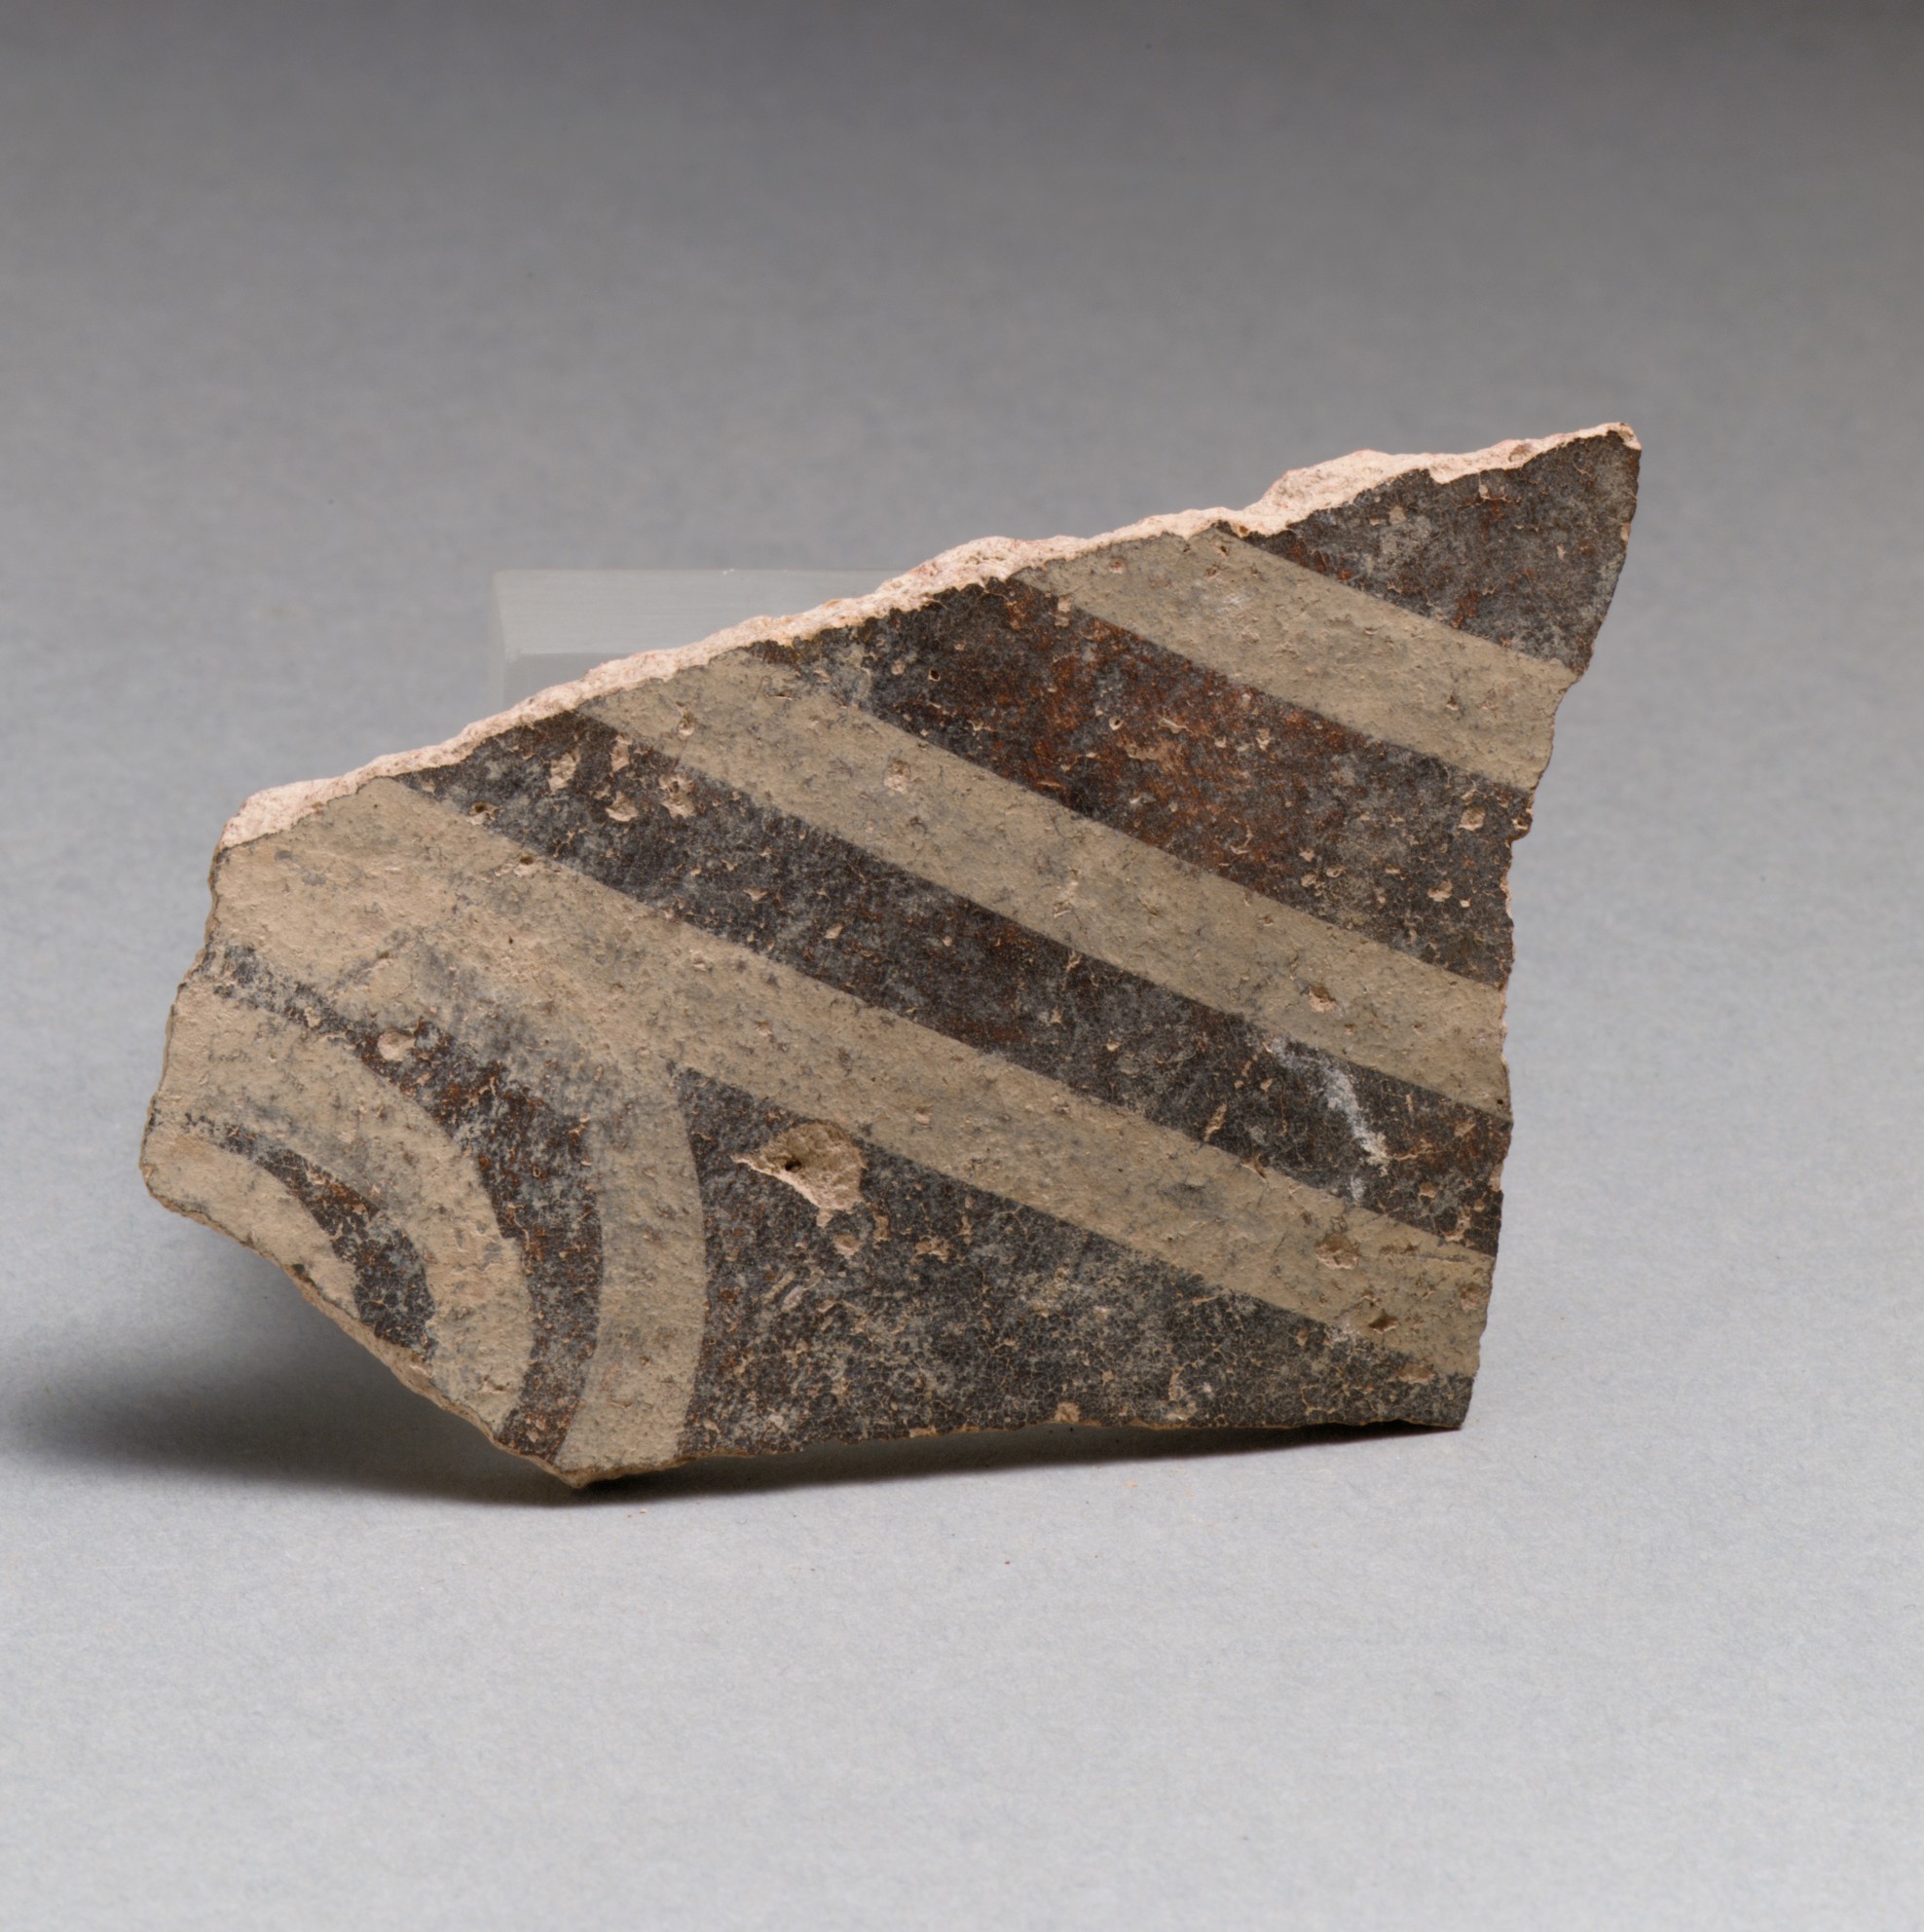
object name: vase fragment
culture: minoan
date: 2600-2000 BCE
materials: terracotta